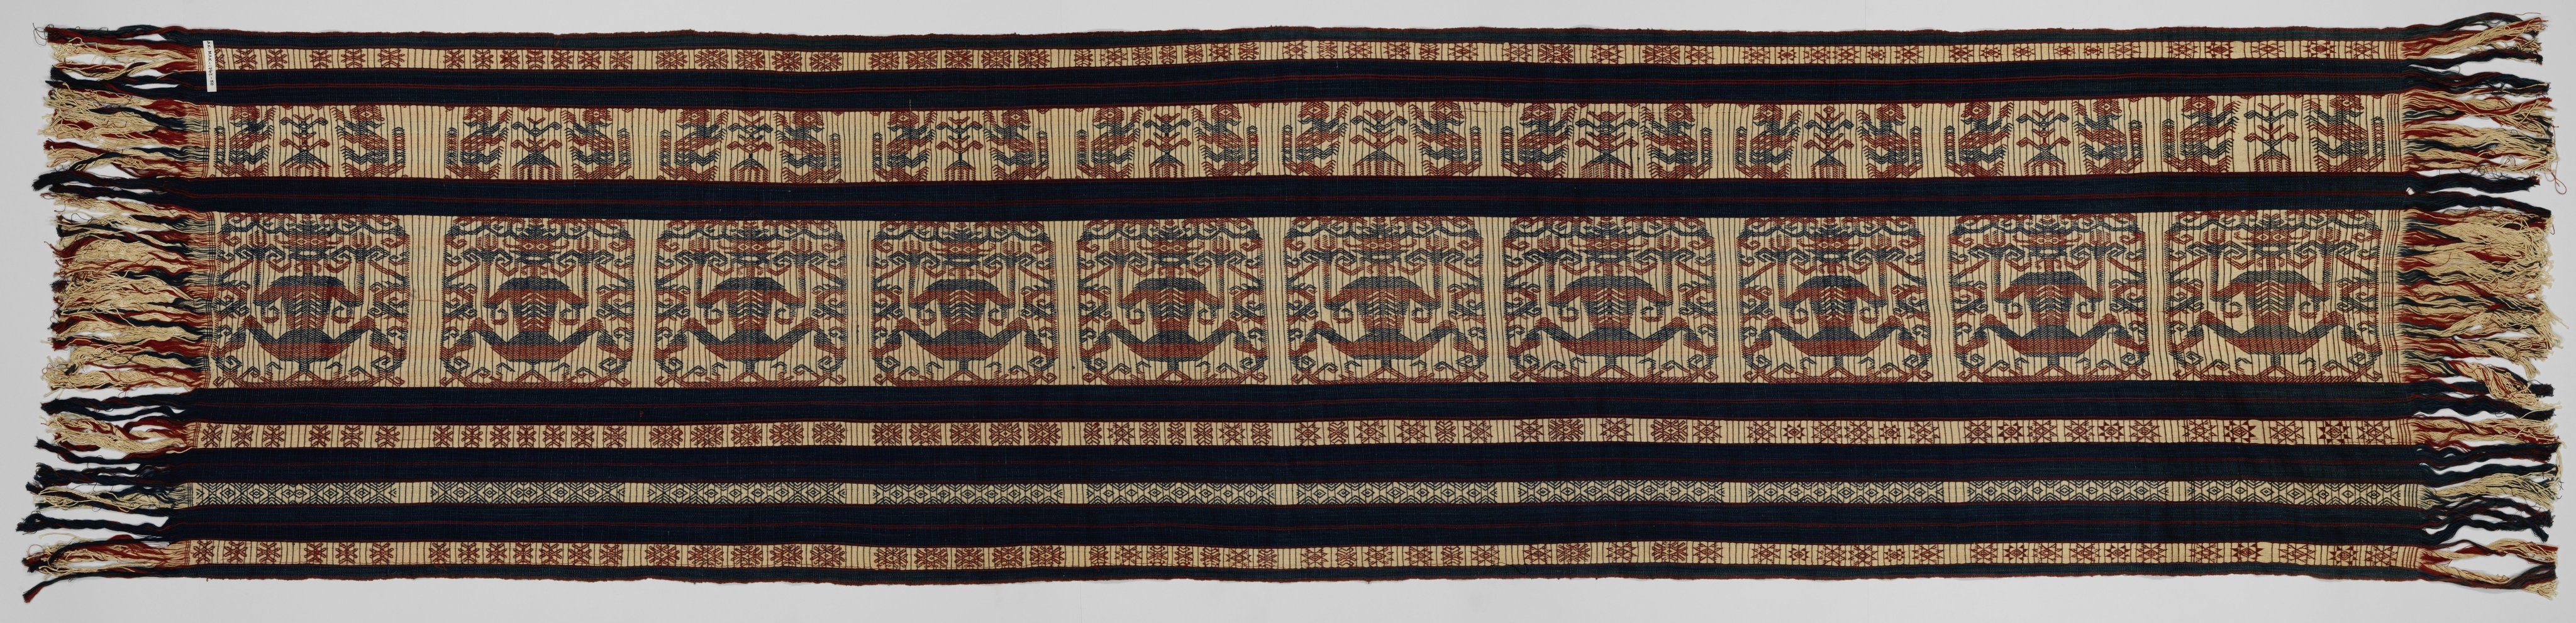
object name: omslagdoek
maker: Anonymous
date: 1900-1949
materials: cotton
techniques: weave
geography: soemba